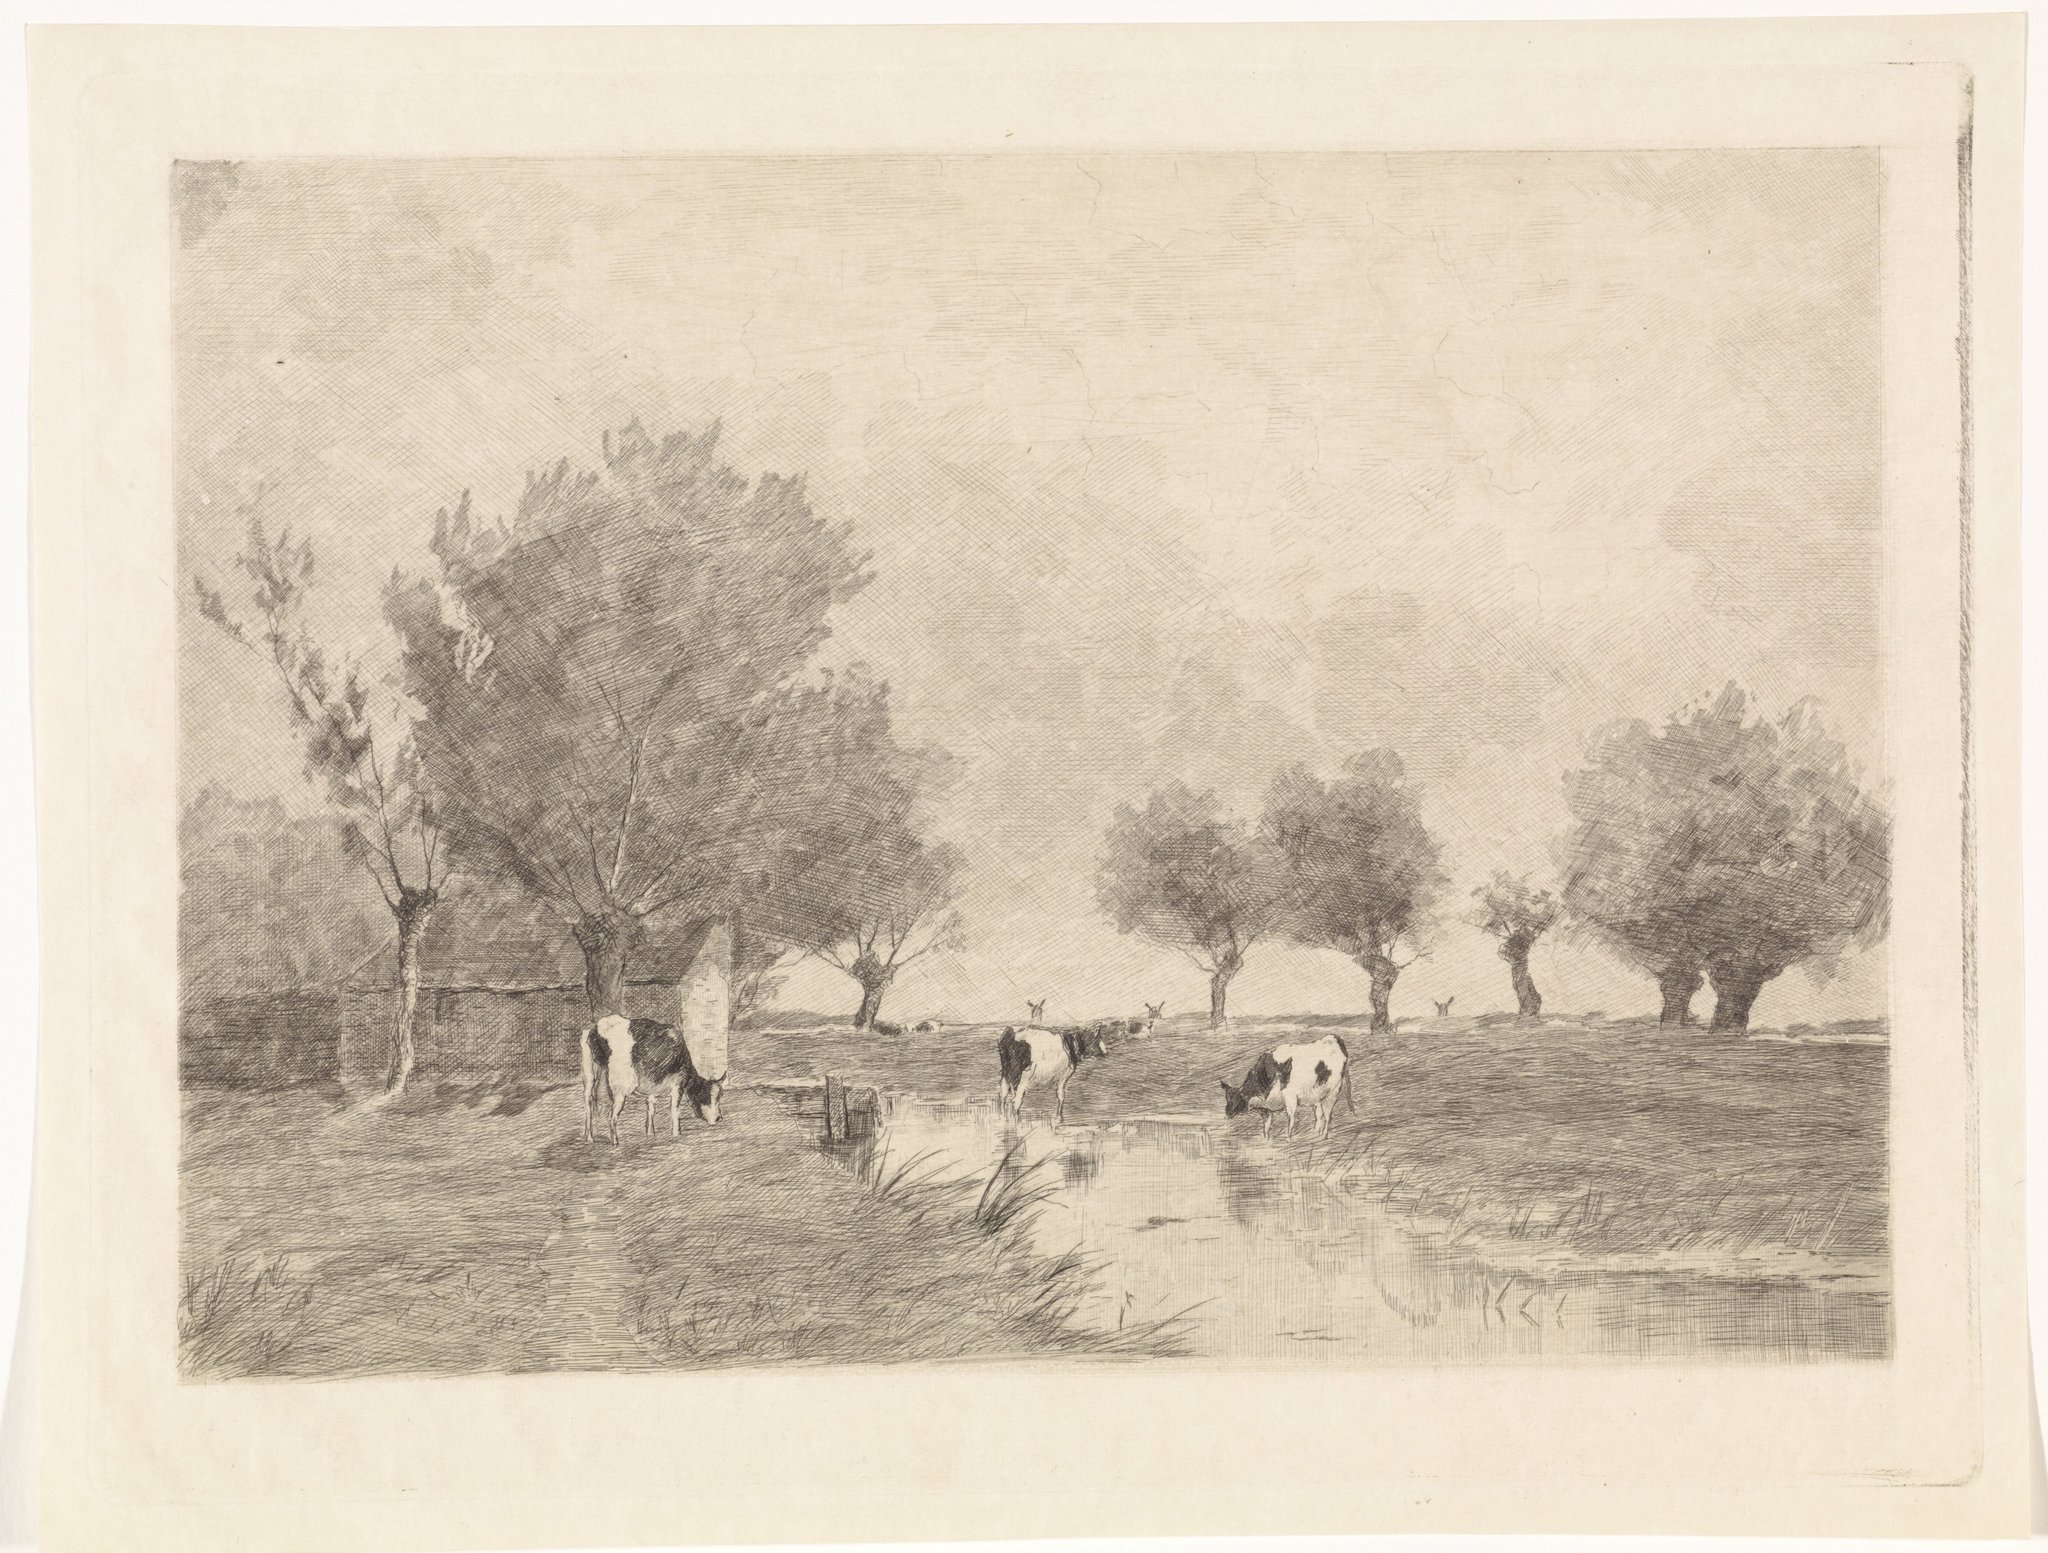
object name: print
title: Landschap met drie koeien bij een sloot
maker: elias stark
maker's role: draughtsman, print maker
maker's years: 1849-1933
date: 1859-1890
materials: paper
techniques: drypoint, etching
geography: netherlands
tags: cow, swamps and polders, trees: willow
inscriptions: collector's mark: Lugt 2228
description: Landschap met drie koeien bij een sloot. Links een huis en aan de horizon drie molens.